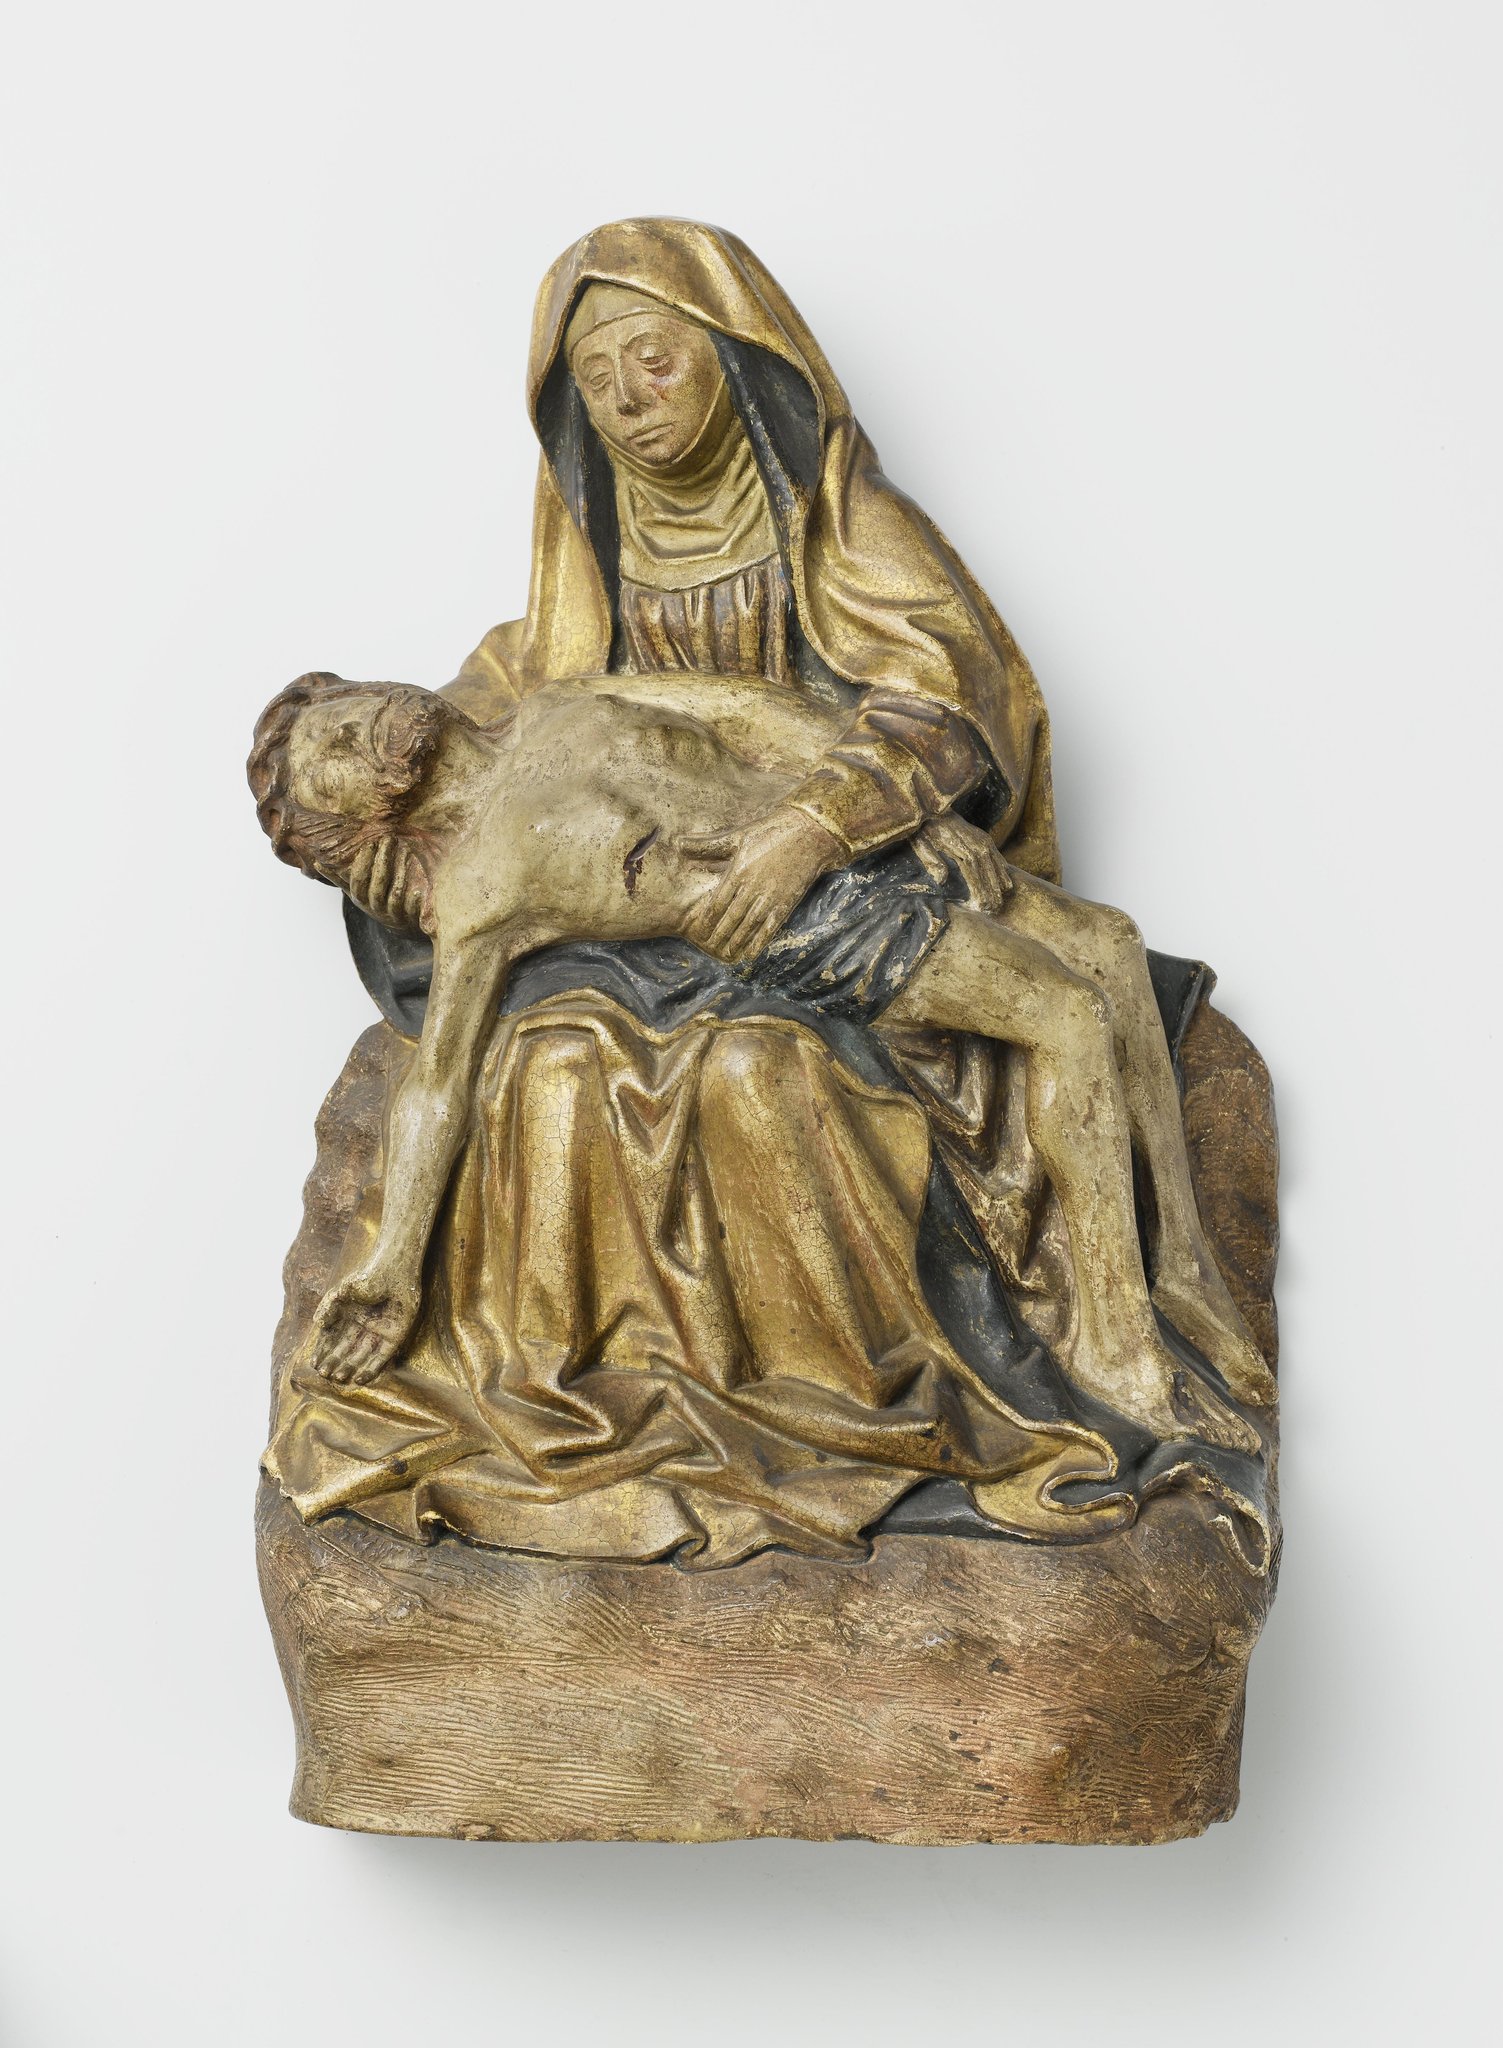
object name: figure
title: Pietà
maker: Anonymous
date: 1450-1475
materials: clay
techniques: polychromy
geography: utrecht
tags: the dead christ in mary's lap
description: Using a mould, identical miniature statues were mass-produced in pipe clay (white-fired clay), then fired and painted. This statuette is among the more ambitious works of these clay sculptors and was once part of an altar.